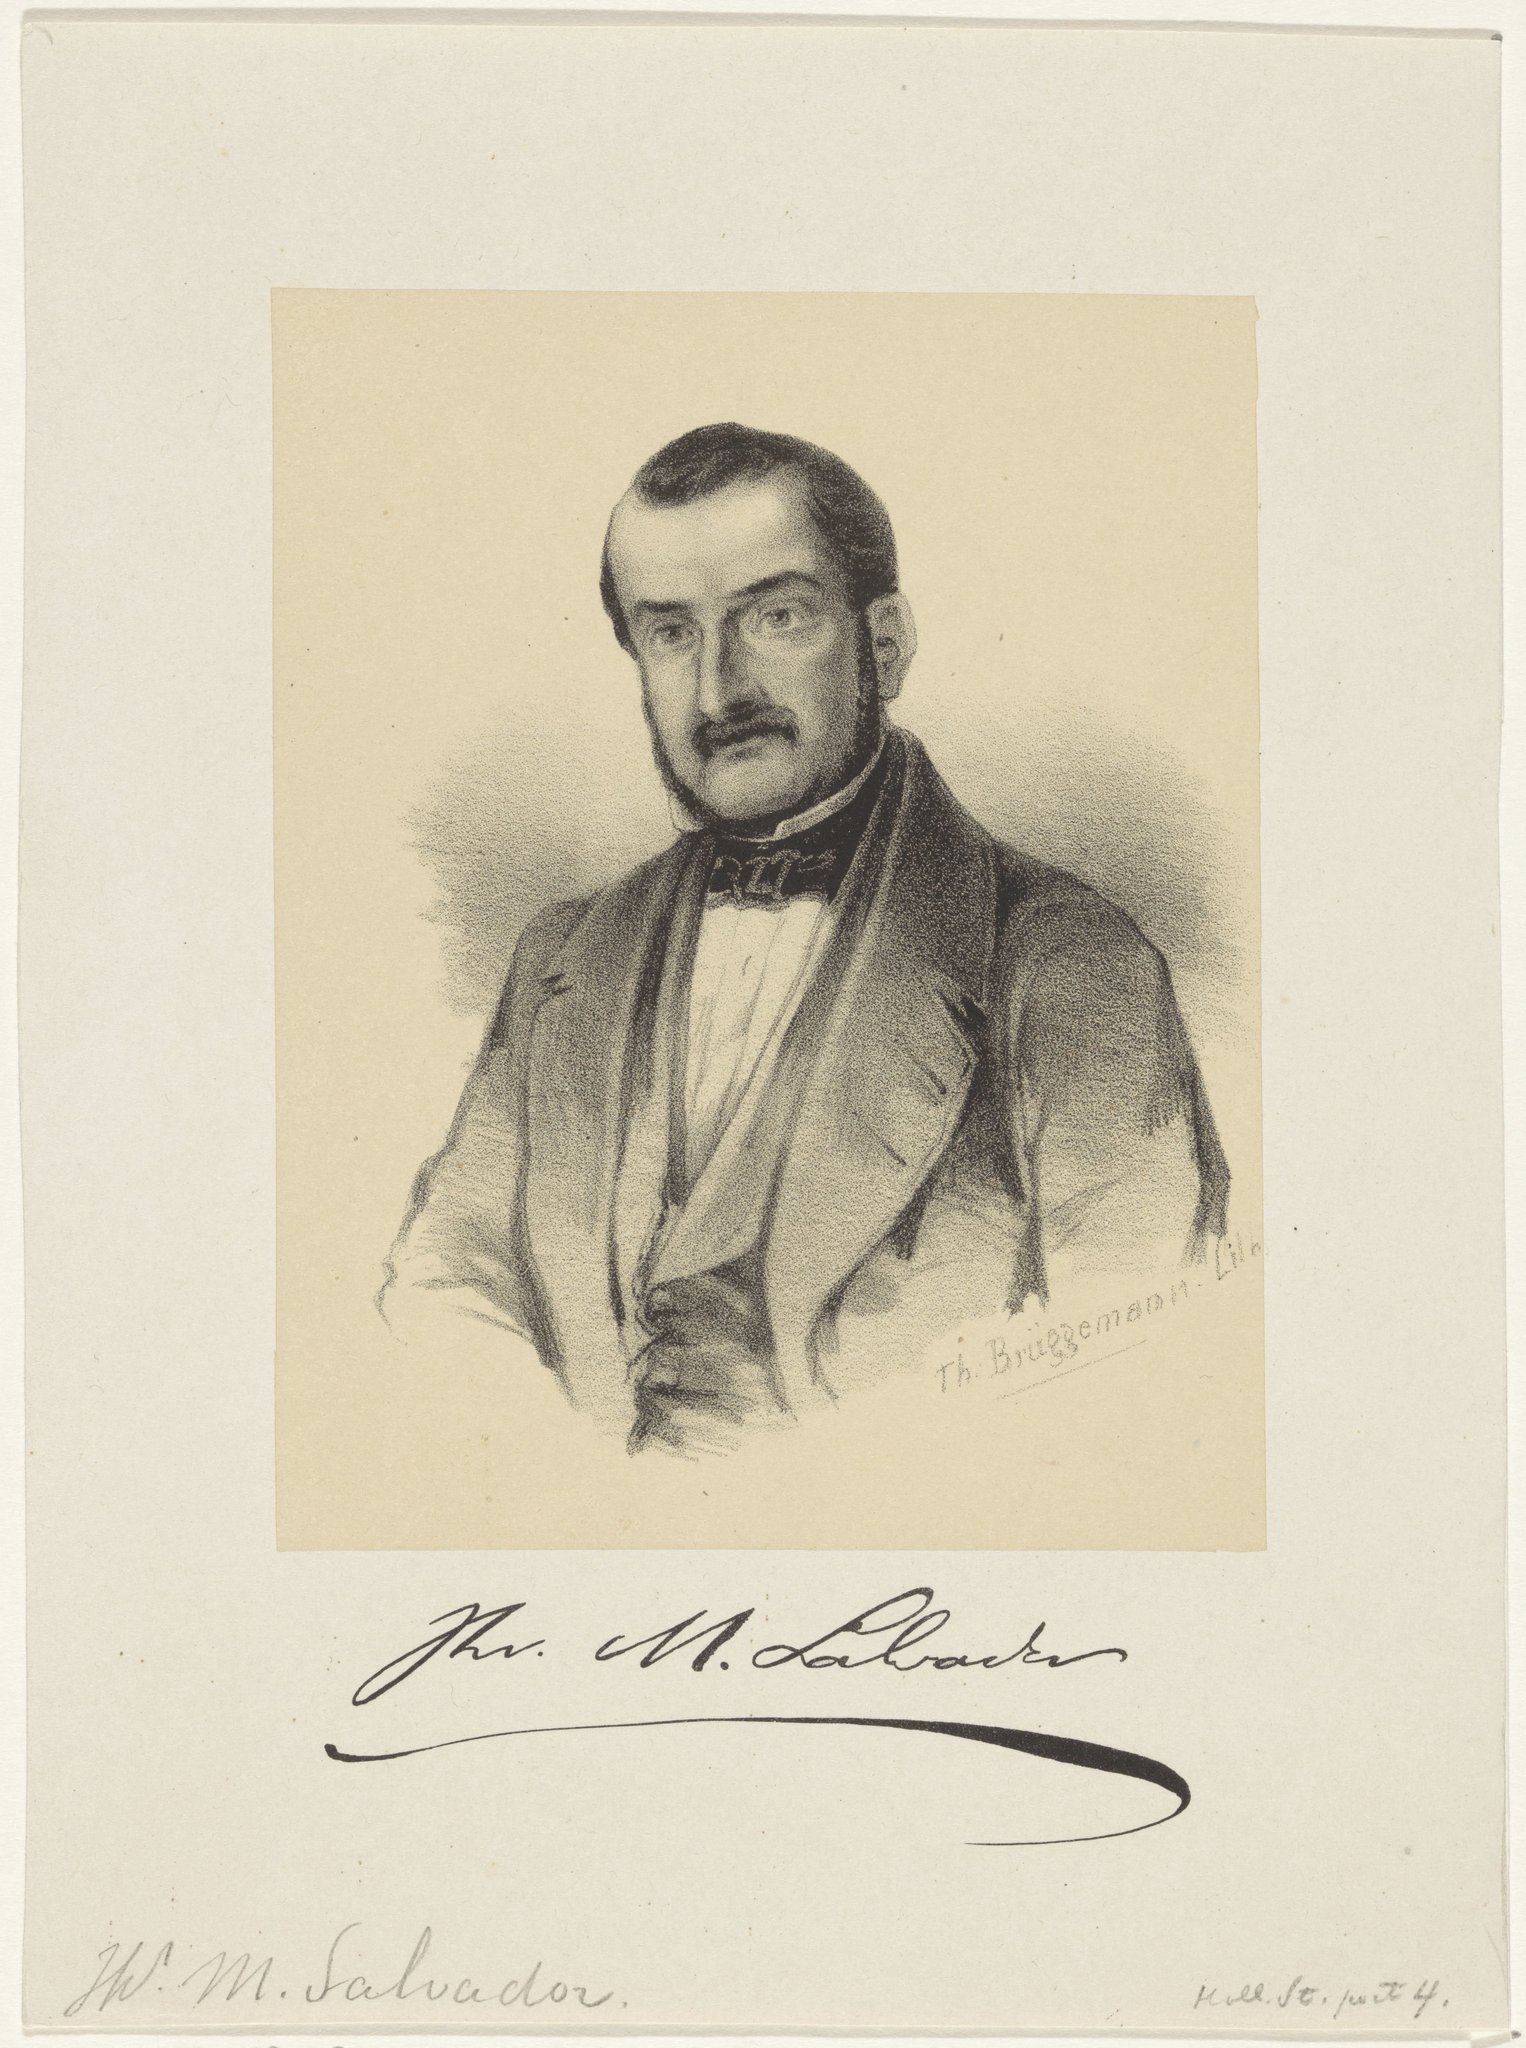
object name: print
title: Portret van Mozes Salvador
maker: theodor brüggemann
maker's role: print maker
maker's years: 1822-1888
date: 1832-1888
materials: paper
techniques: lithograph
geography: amsterdam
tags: politician, historical persons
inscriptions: collector's mark: Lugt 964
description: De geportretteerde draagt lange bakkebaarden en een snor. Onder het portret zijn signatuur.